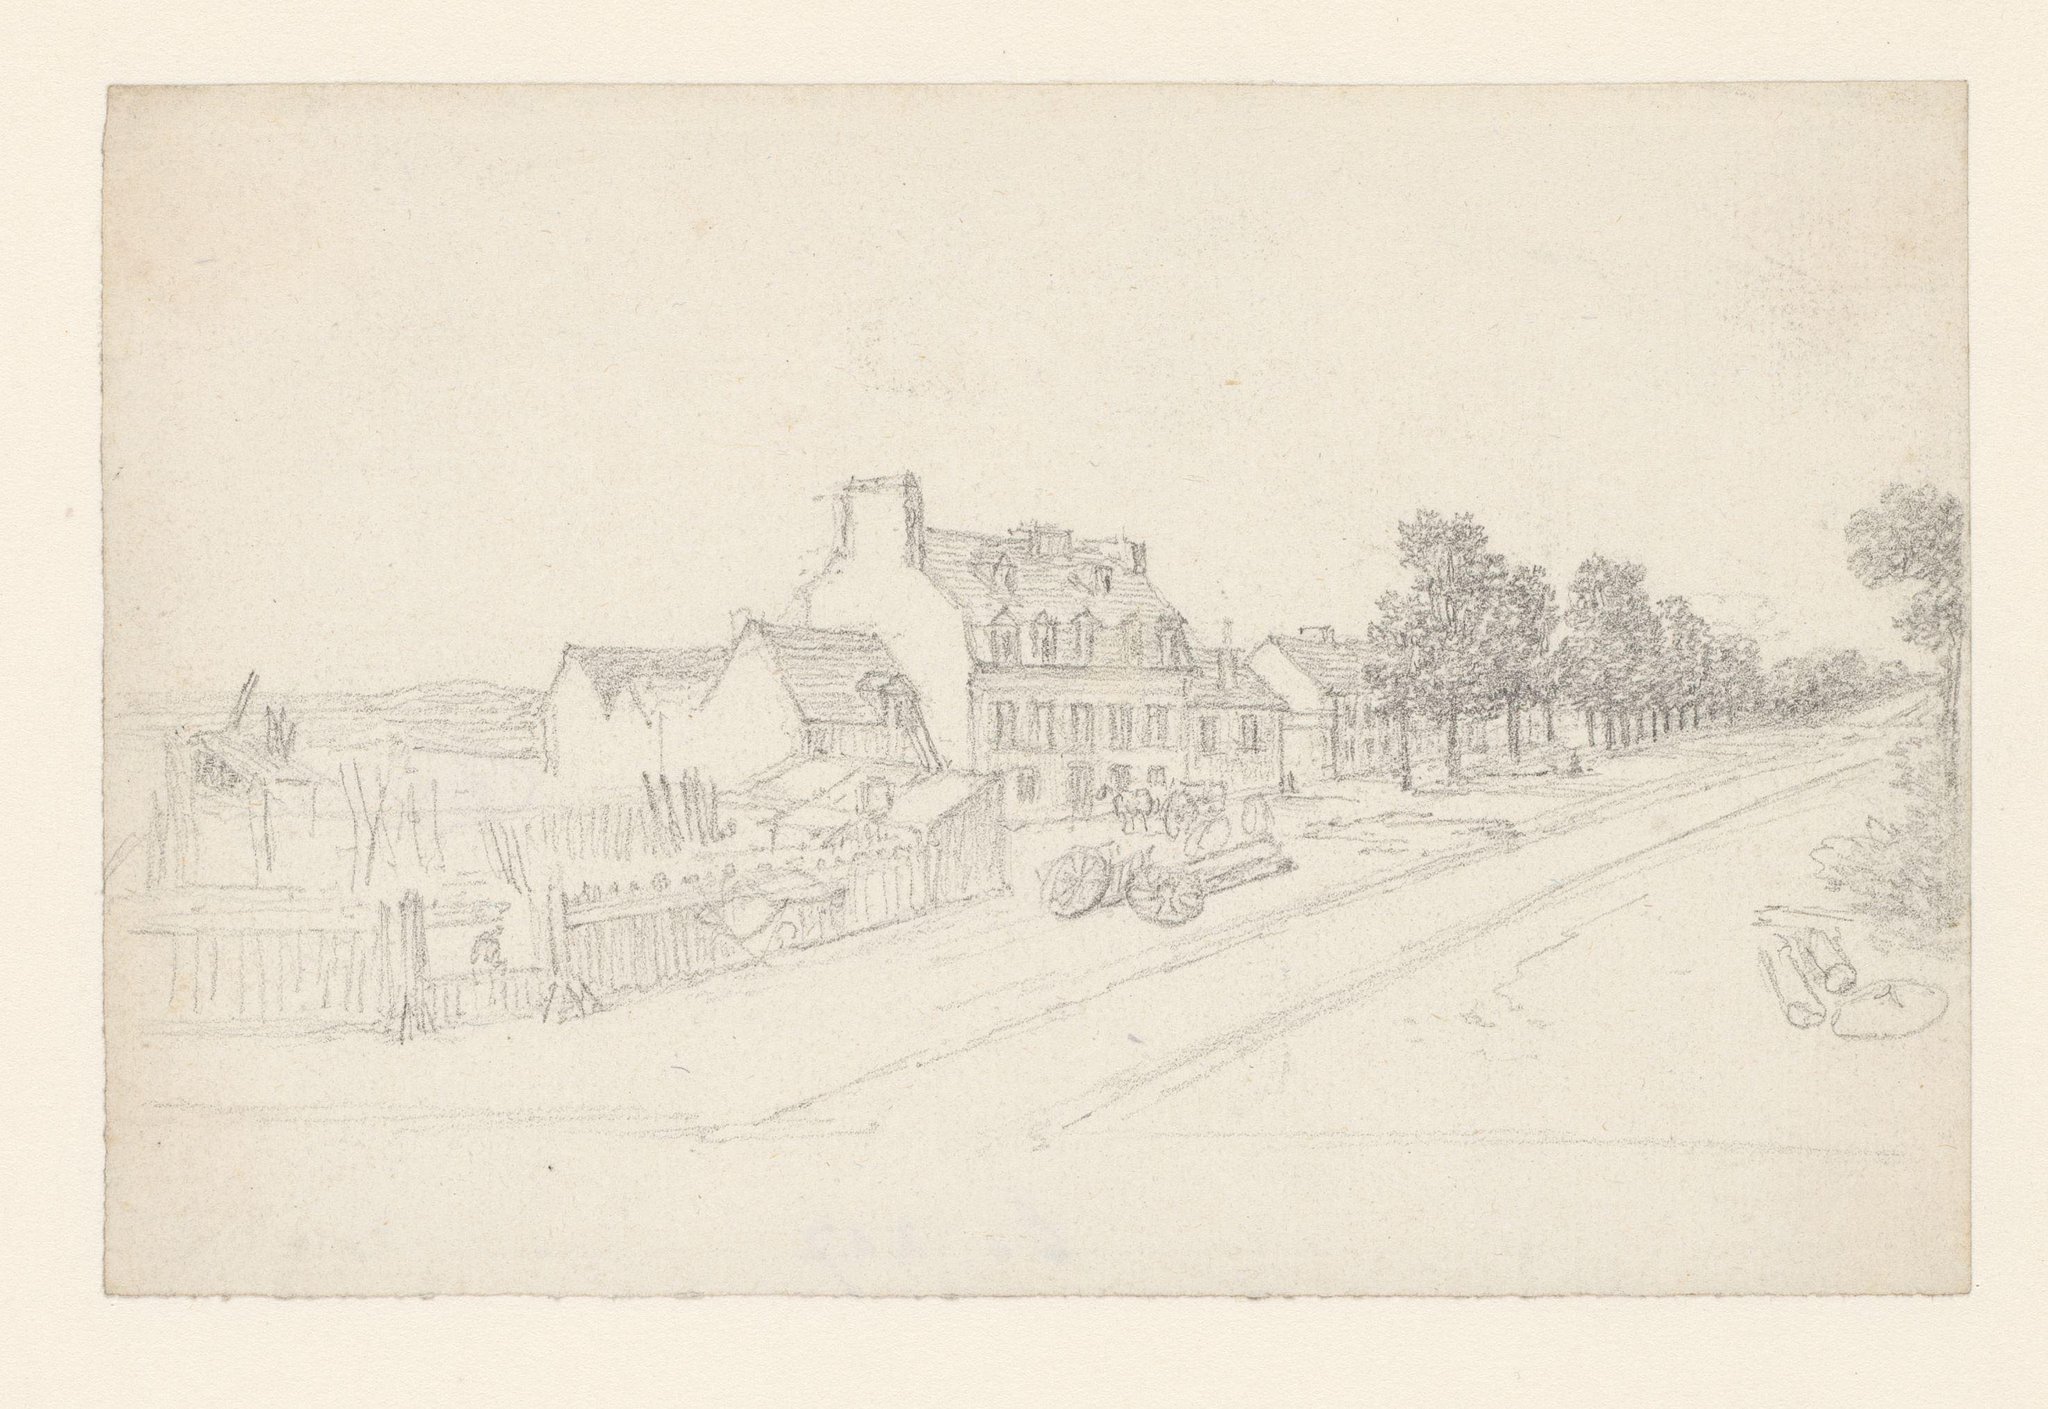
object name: drawing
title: Huis met timmerwerf aan een straatweg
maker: georges michel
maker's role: draughtsman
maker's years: 1763-1843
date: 1773-1843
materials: paper, pencil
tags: industries ~ wood, public road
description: Een van 120 tekeningen, afkomstig uit een 19e eeuws album met tekeningen van Georges Michel.